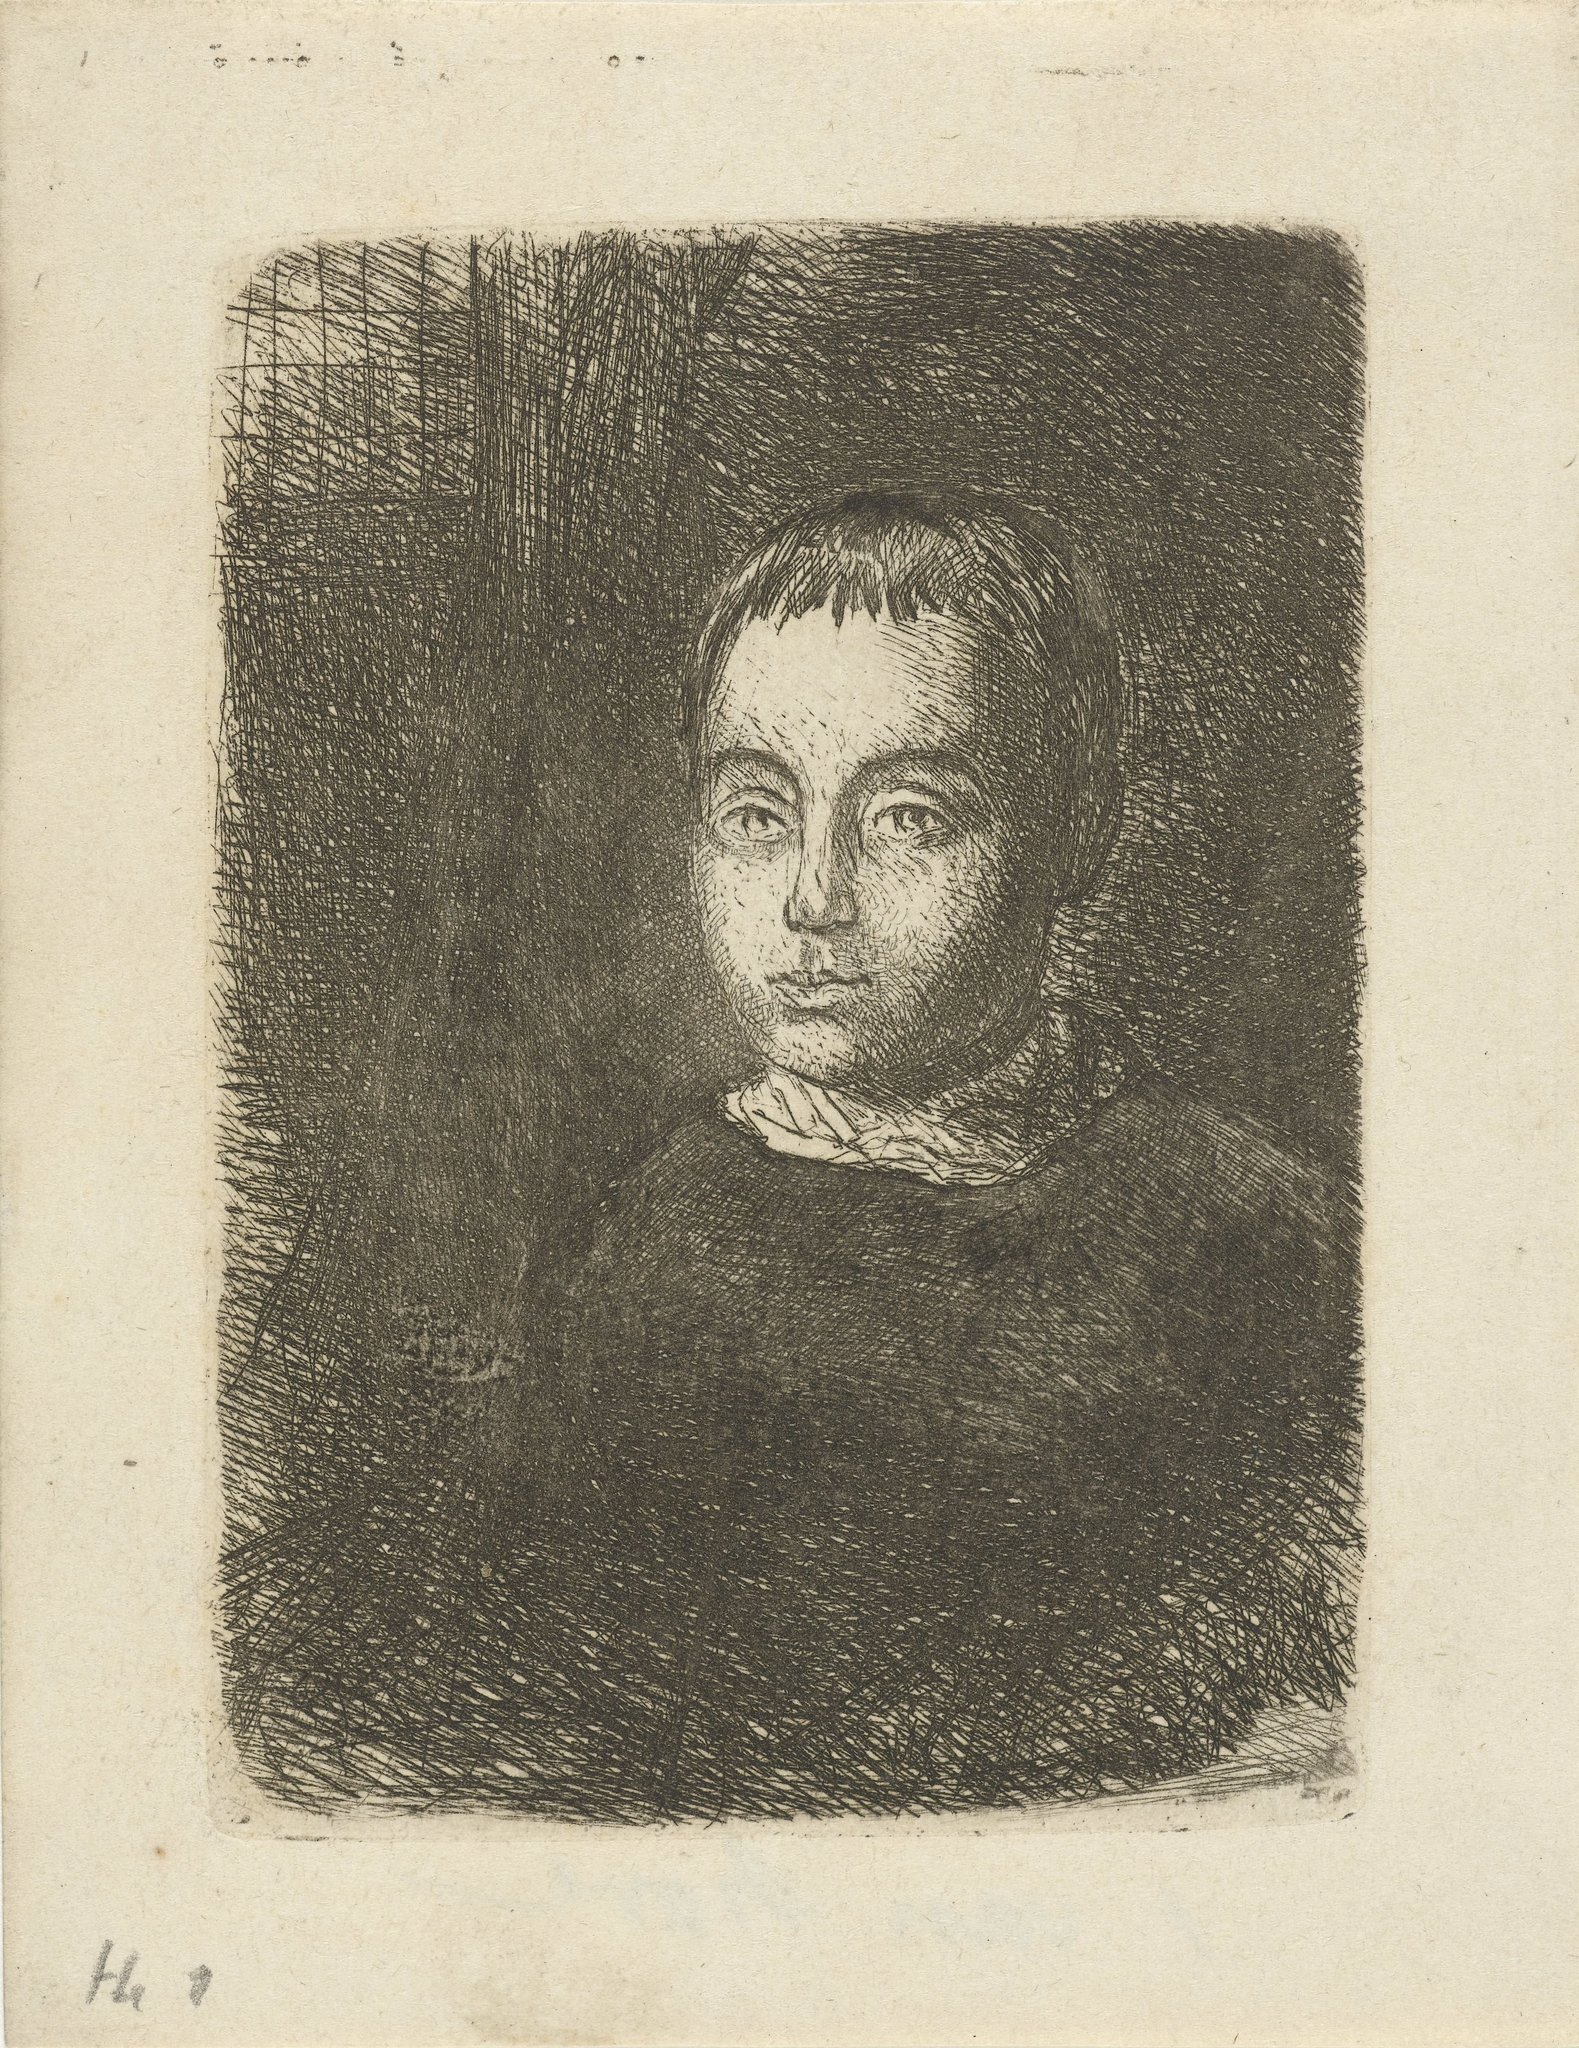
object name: print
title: Portret van een jongen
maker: huib van hove bz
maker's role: painter, print maker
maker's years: 1814-1867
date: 1824-1864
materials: paper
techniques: etching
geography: low countries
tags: portrait, self-portrait of artist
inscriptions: inscription: ‘I van hove’, collector's mark: Lugt 2228